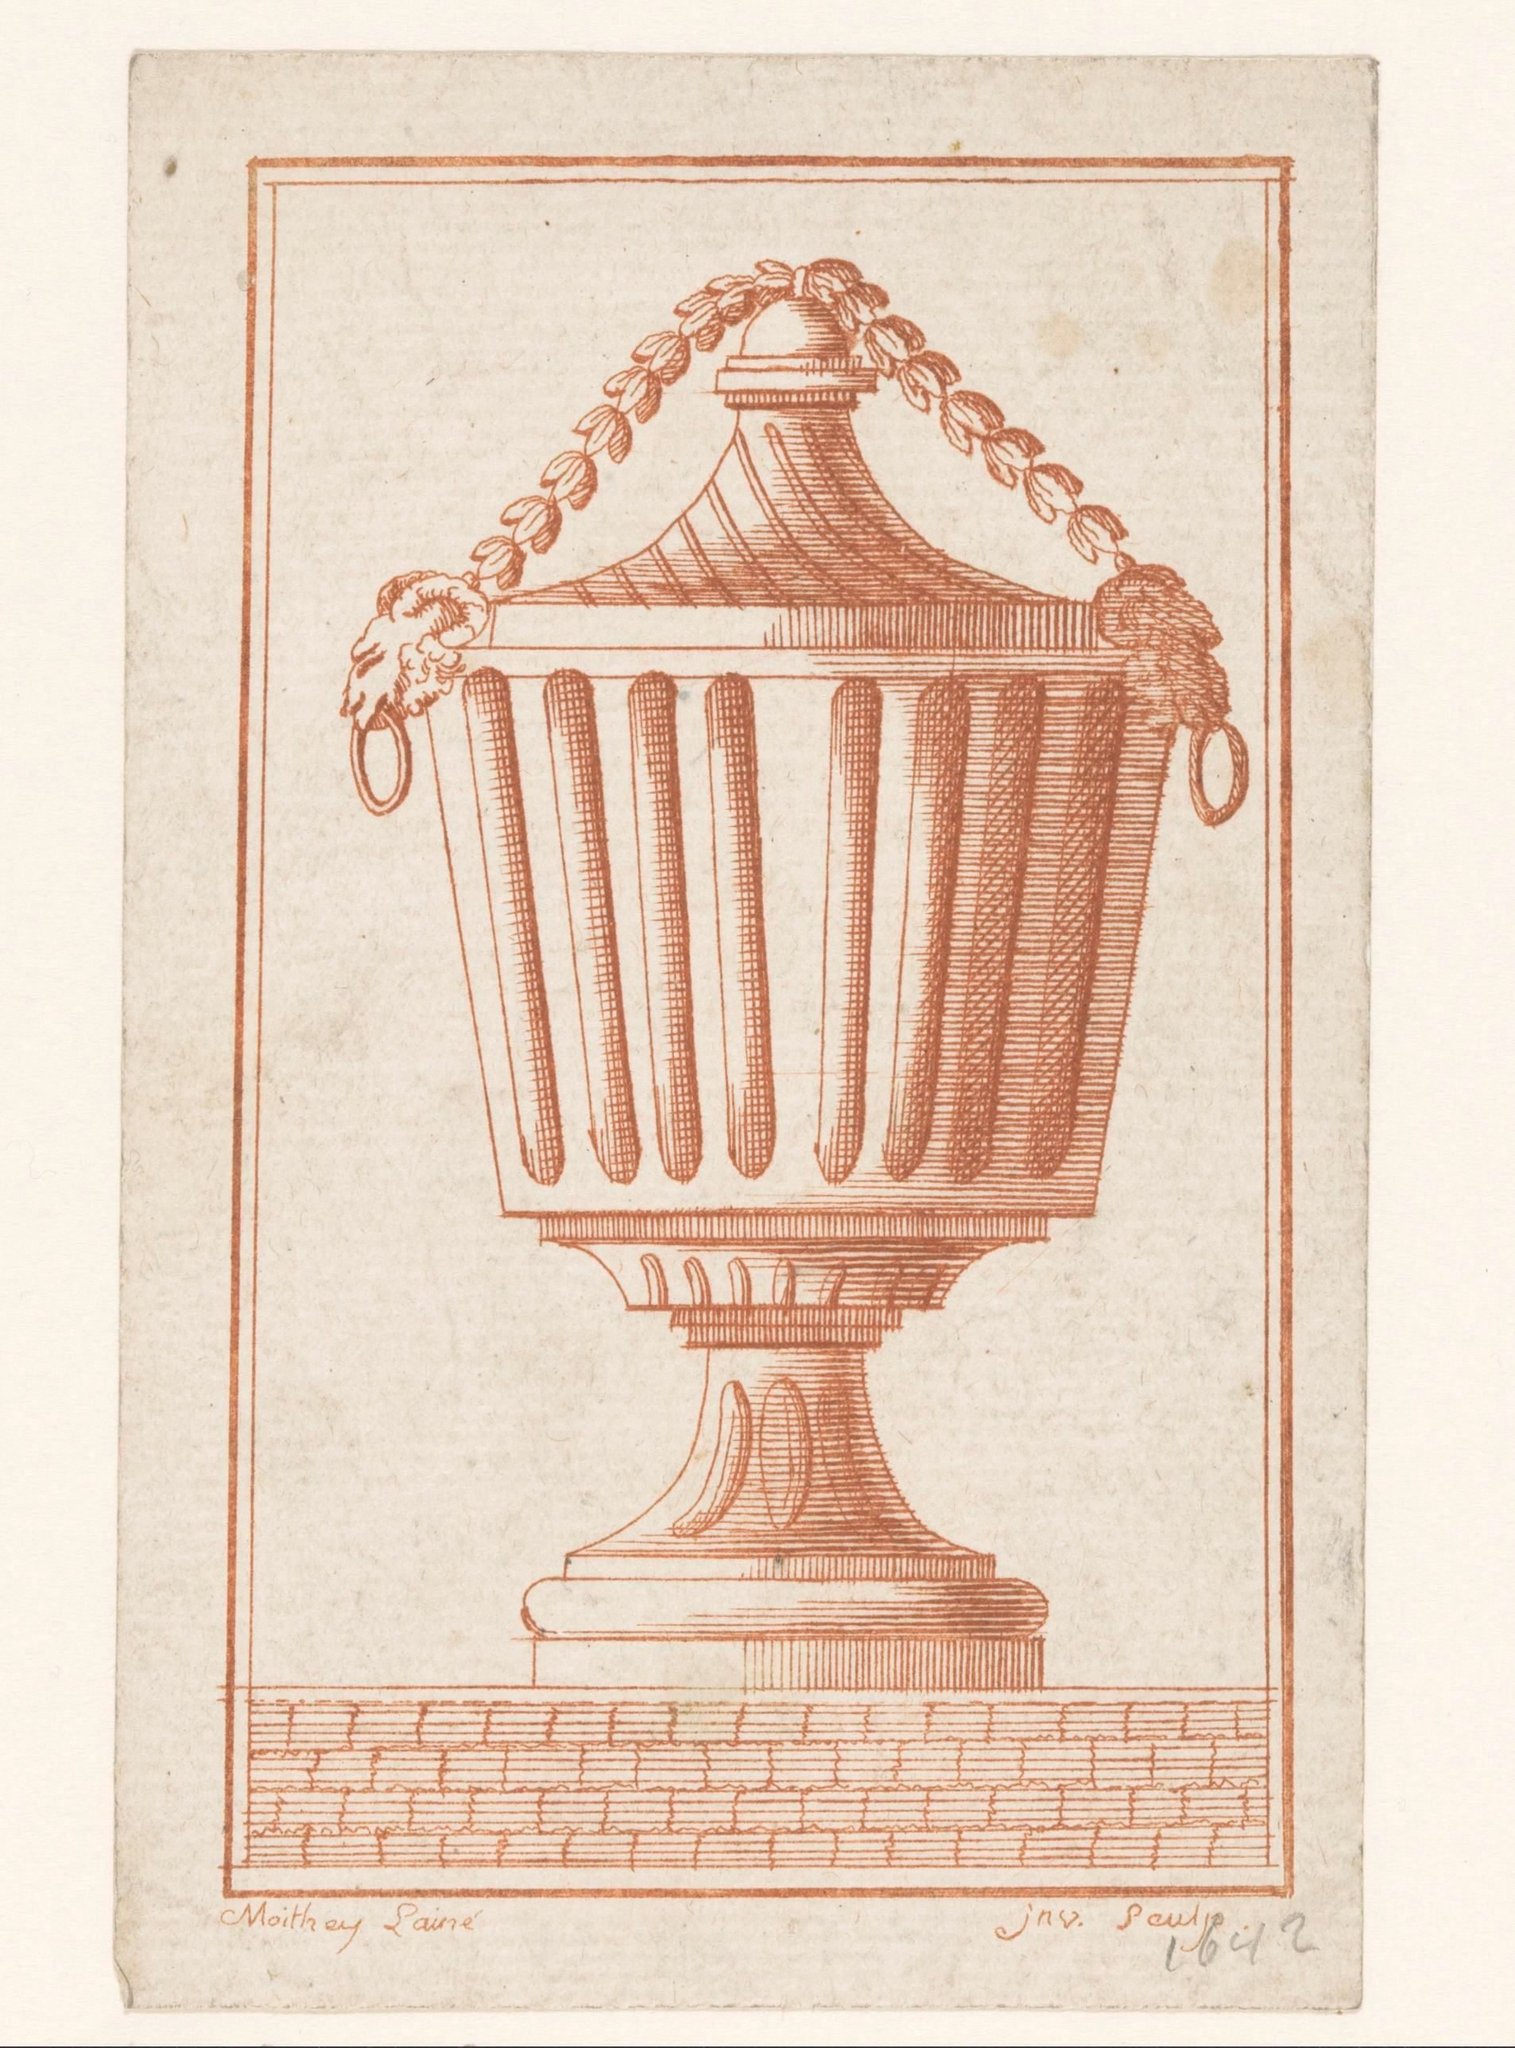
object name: print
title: Antieke vaas met deksel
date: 1767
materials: paper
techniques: etching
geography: paris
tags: vase ~ ornament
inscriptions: collector's mark: Lugt 2228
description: Antieke vaas met deksel, gedecoreerd met guirlande en ramskoppen.